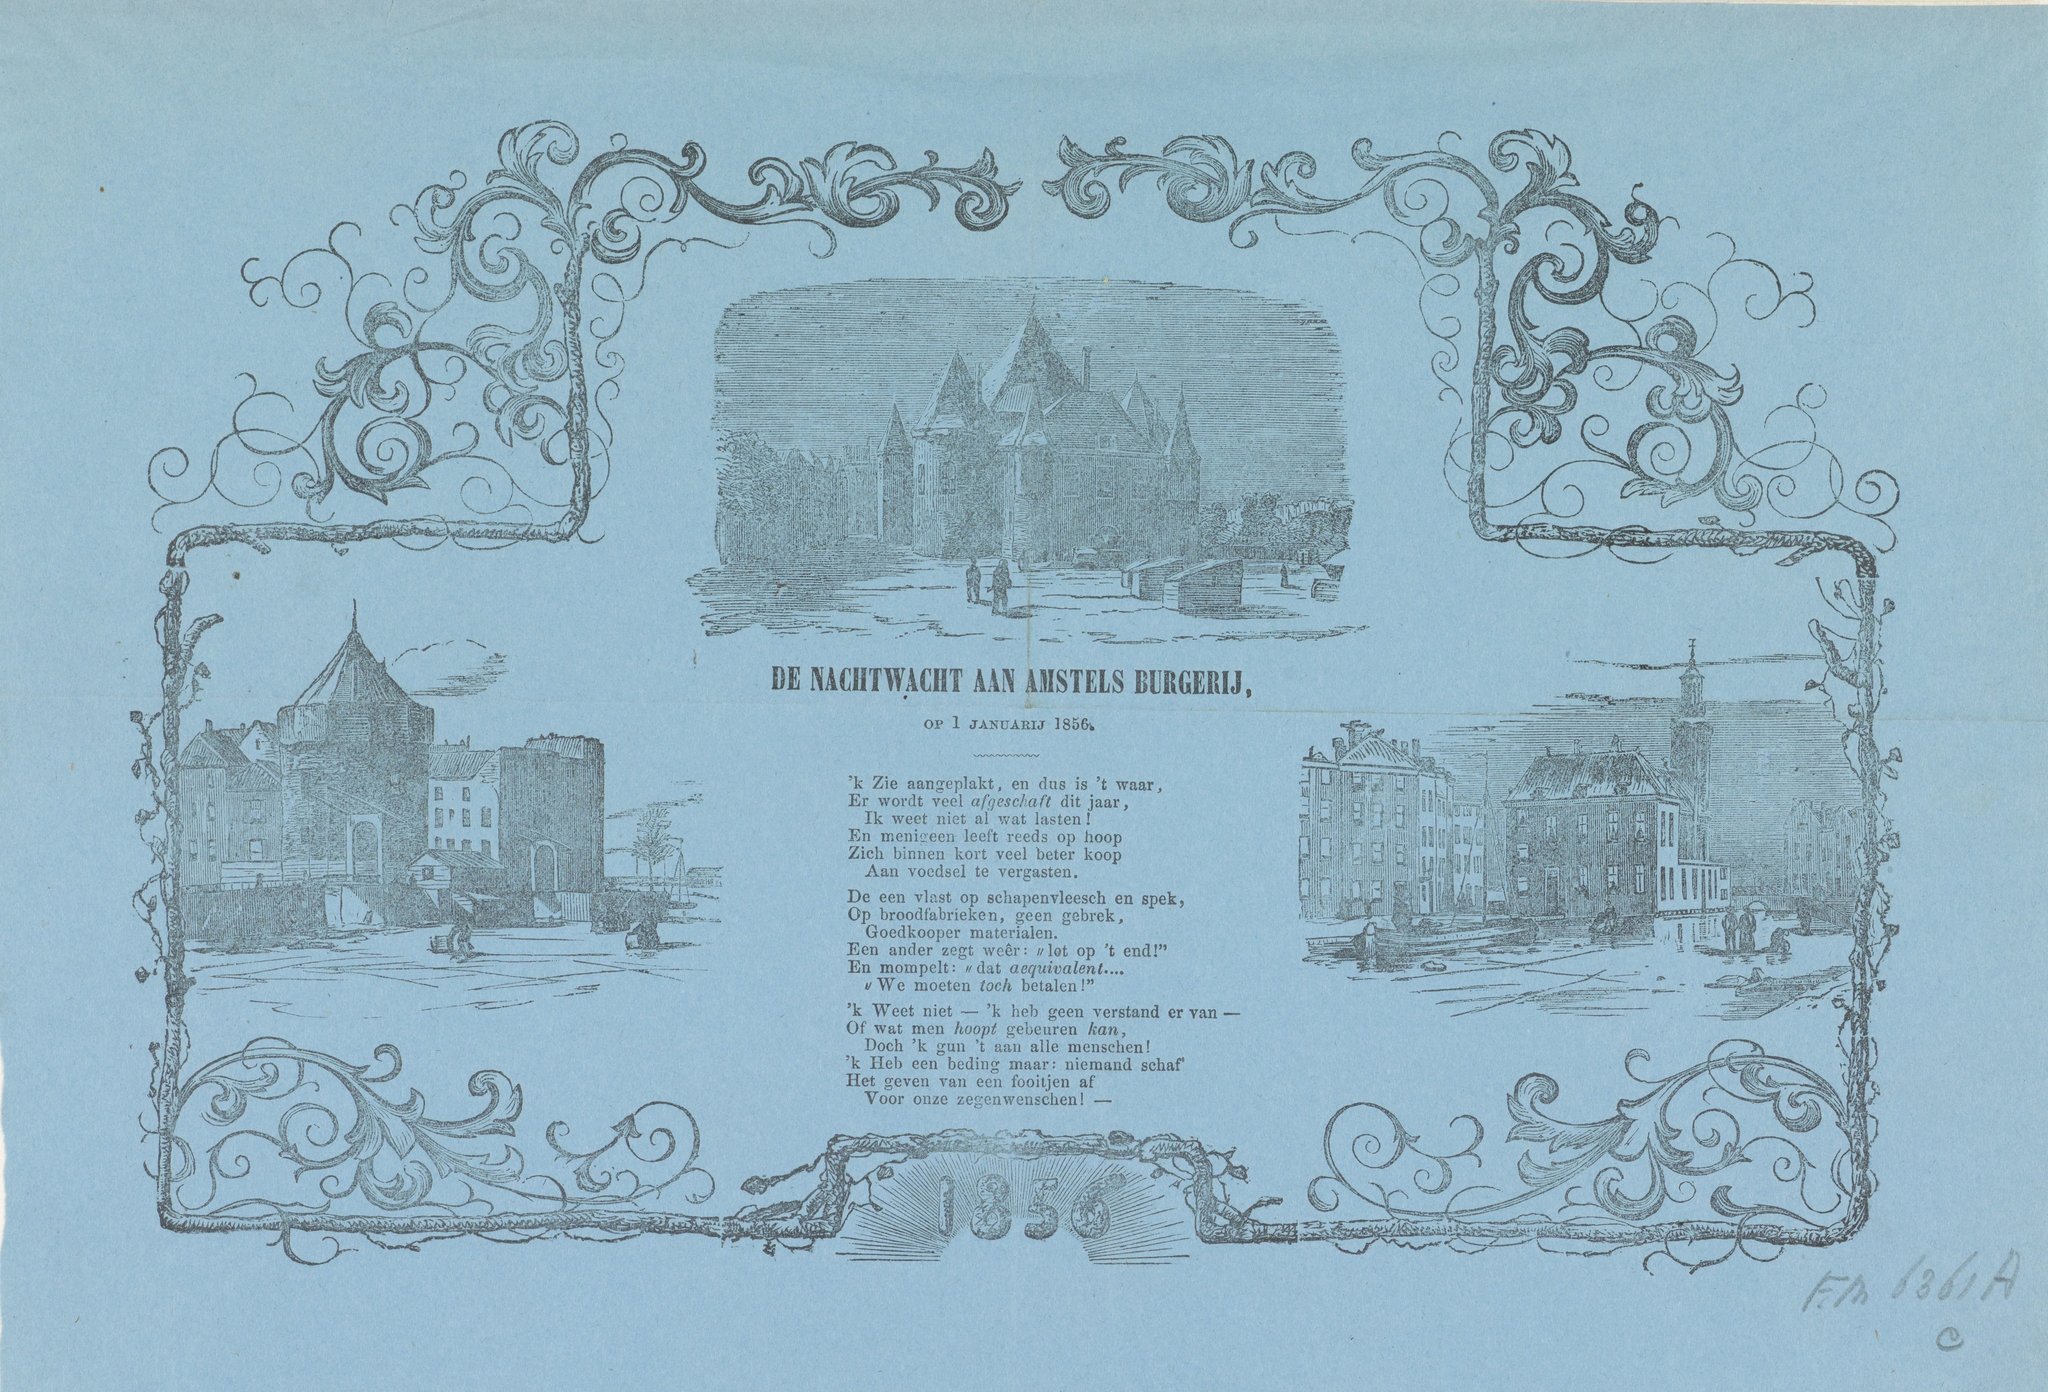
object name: print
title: Nieuwjaarswens van de Amsterdamse nachtwacht voor het jaar 1856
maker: Anonymous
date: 1855-1856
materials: paper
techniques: letterpress printing, engraving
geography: amsterdam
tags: night patrol, amsterdam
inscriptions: collector's mark: Lugt 2228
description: Nieuwjaarswens van de Amsterdamse nachtwacht (ratelwacht) voor het jaar 1856. Centraal een gedicht in drie verzen, daaromheen gezichten op de Waag op de Nieuwmarkt, de Schreierstoren en de Munt.